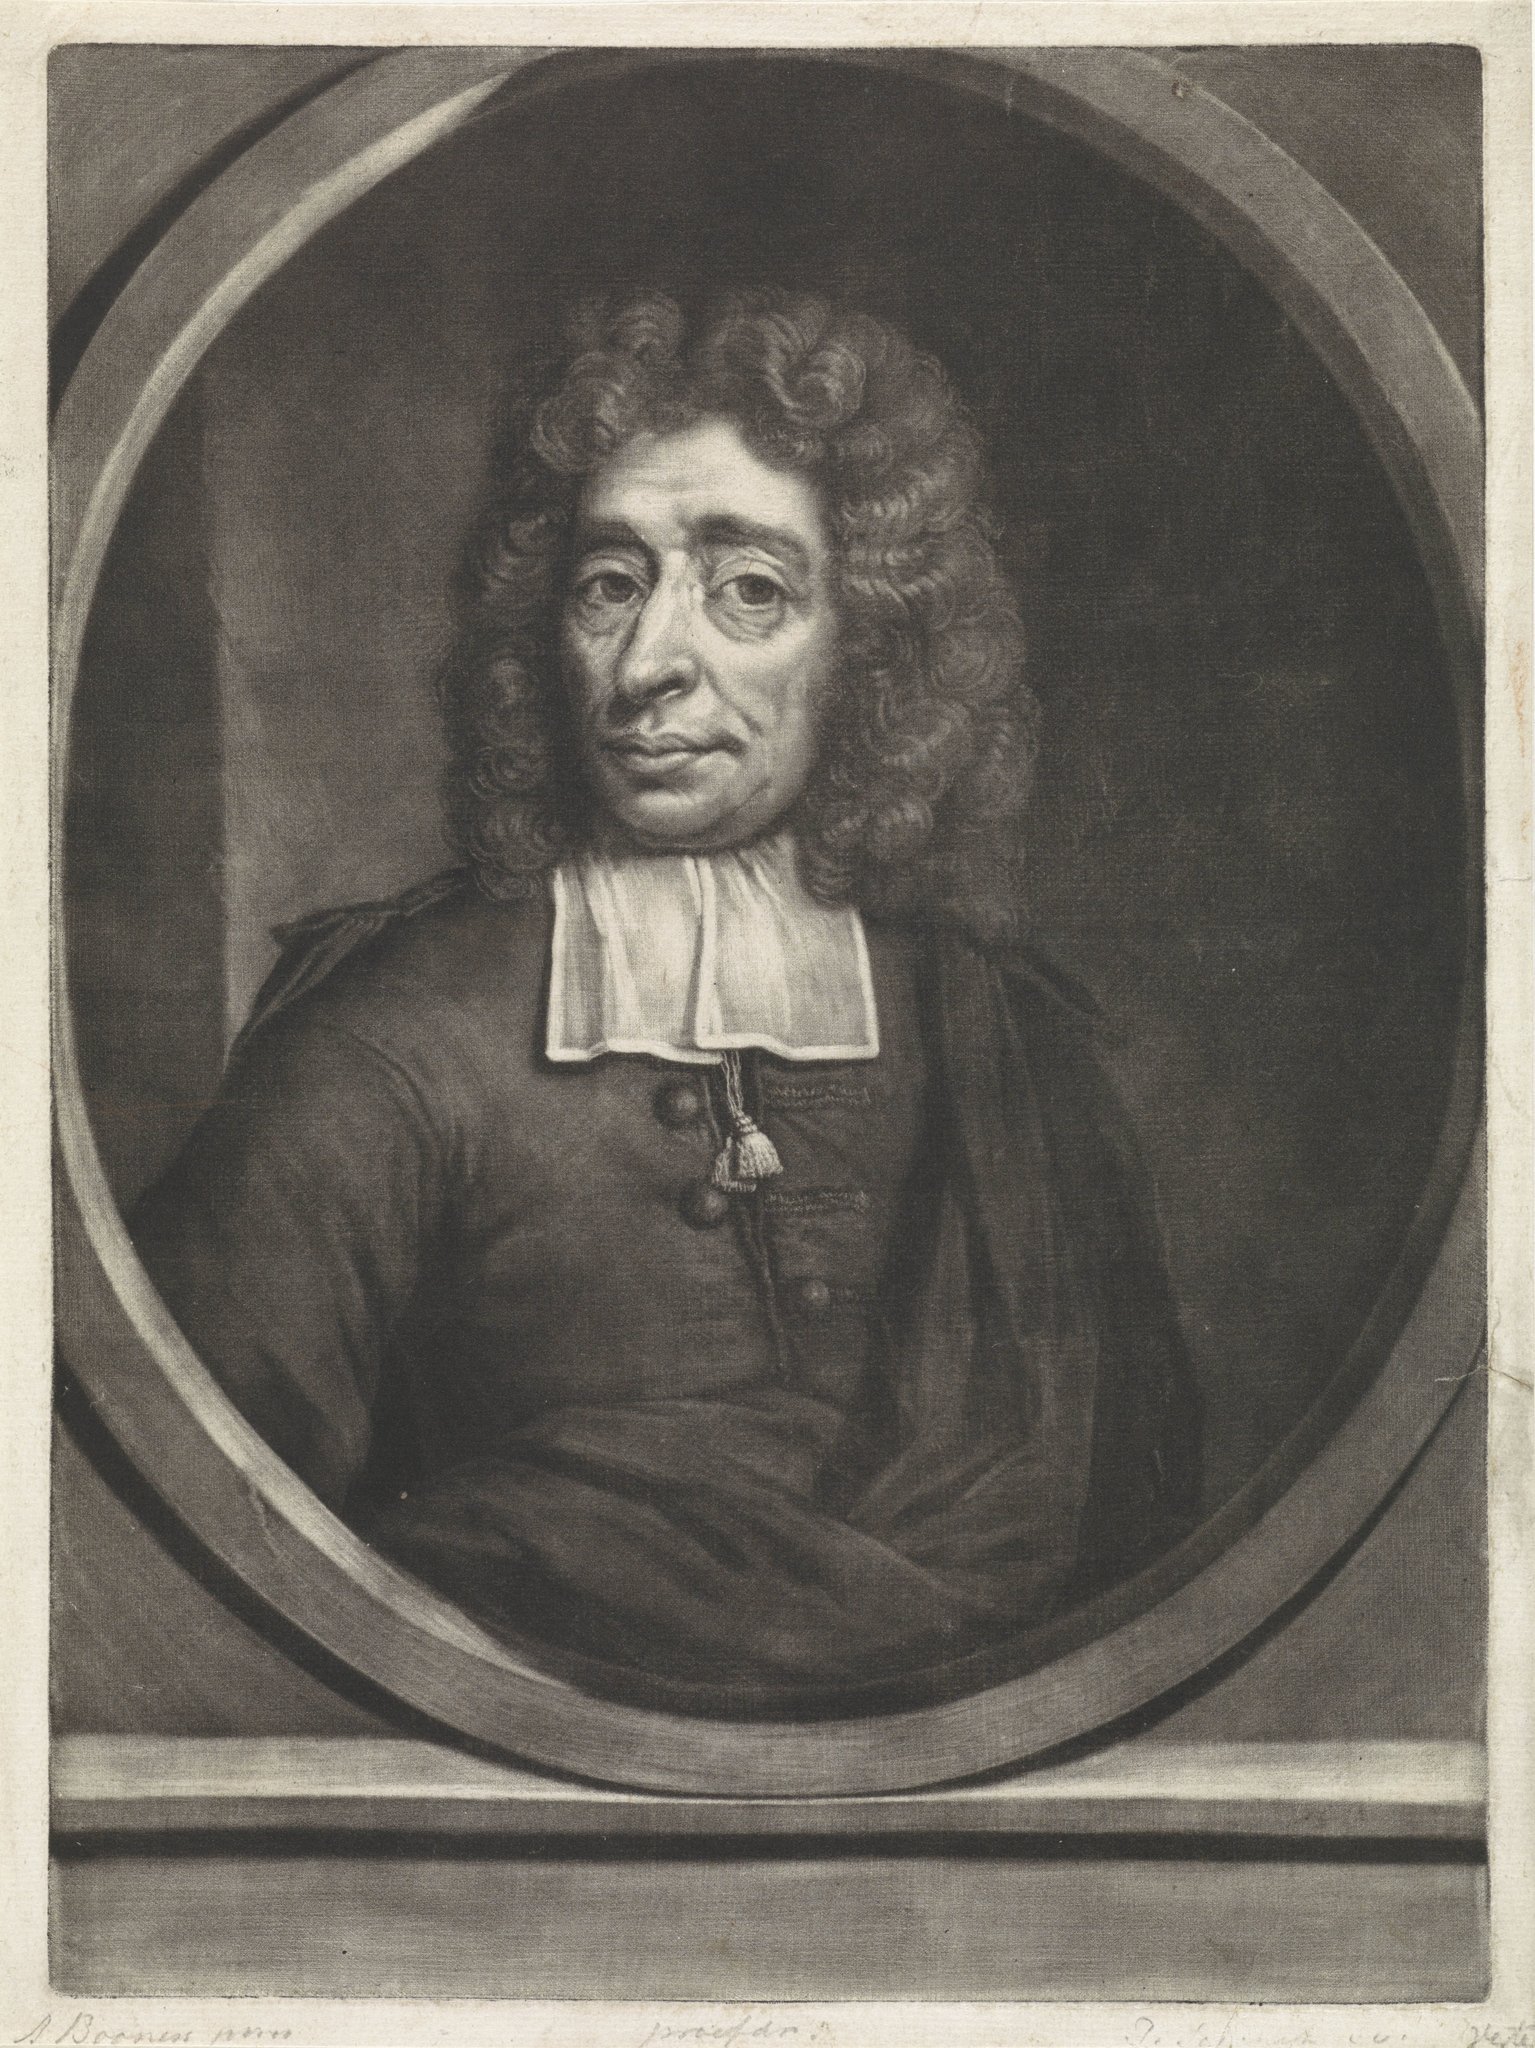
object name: print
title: Portret van Jacobus Streso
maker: frederik boonen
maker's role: print maker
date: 1708-1800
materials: paper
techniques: mezzotint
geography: middelburg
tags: amsterdam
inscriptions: collector's mark: Lugt 2228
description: Portret van Jacobus Streso, predikant in onder andere Amsterdam.